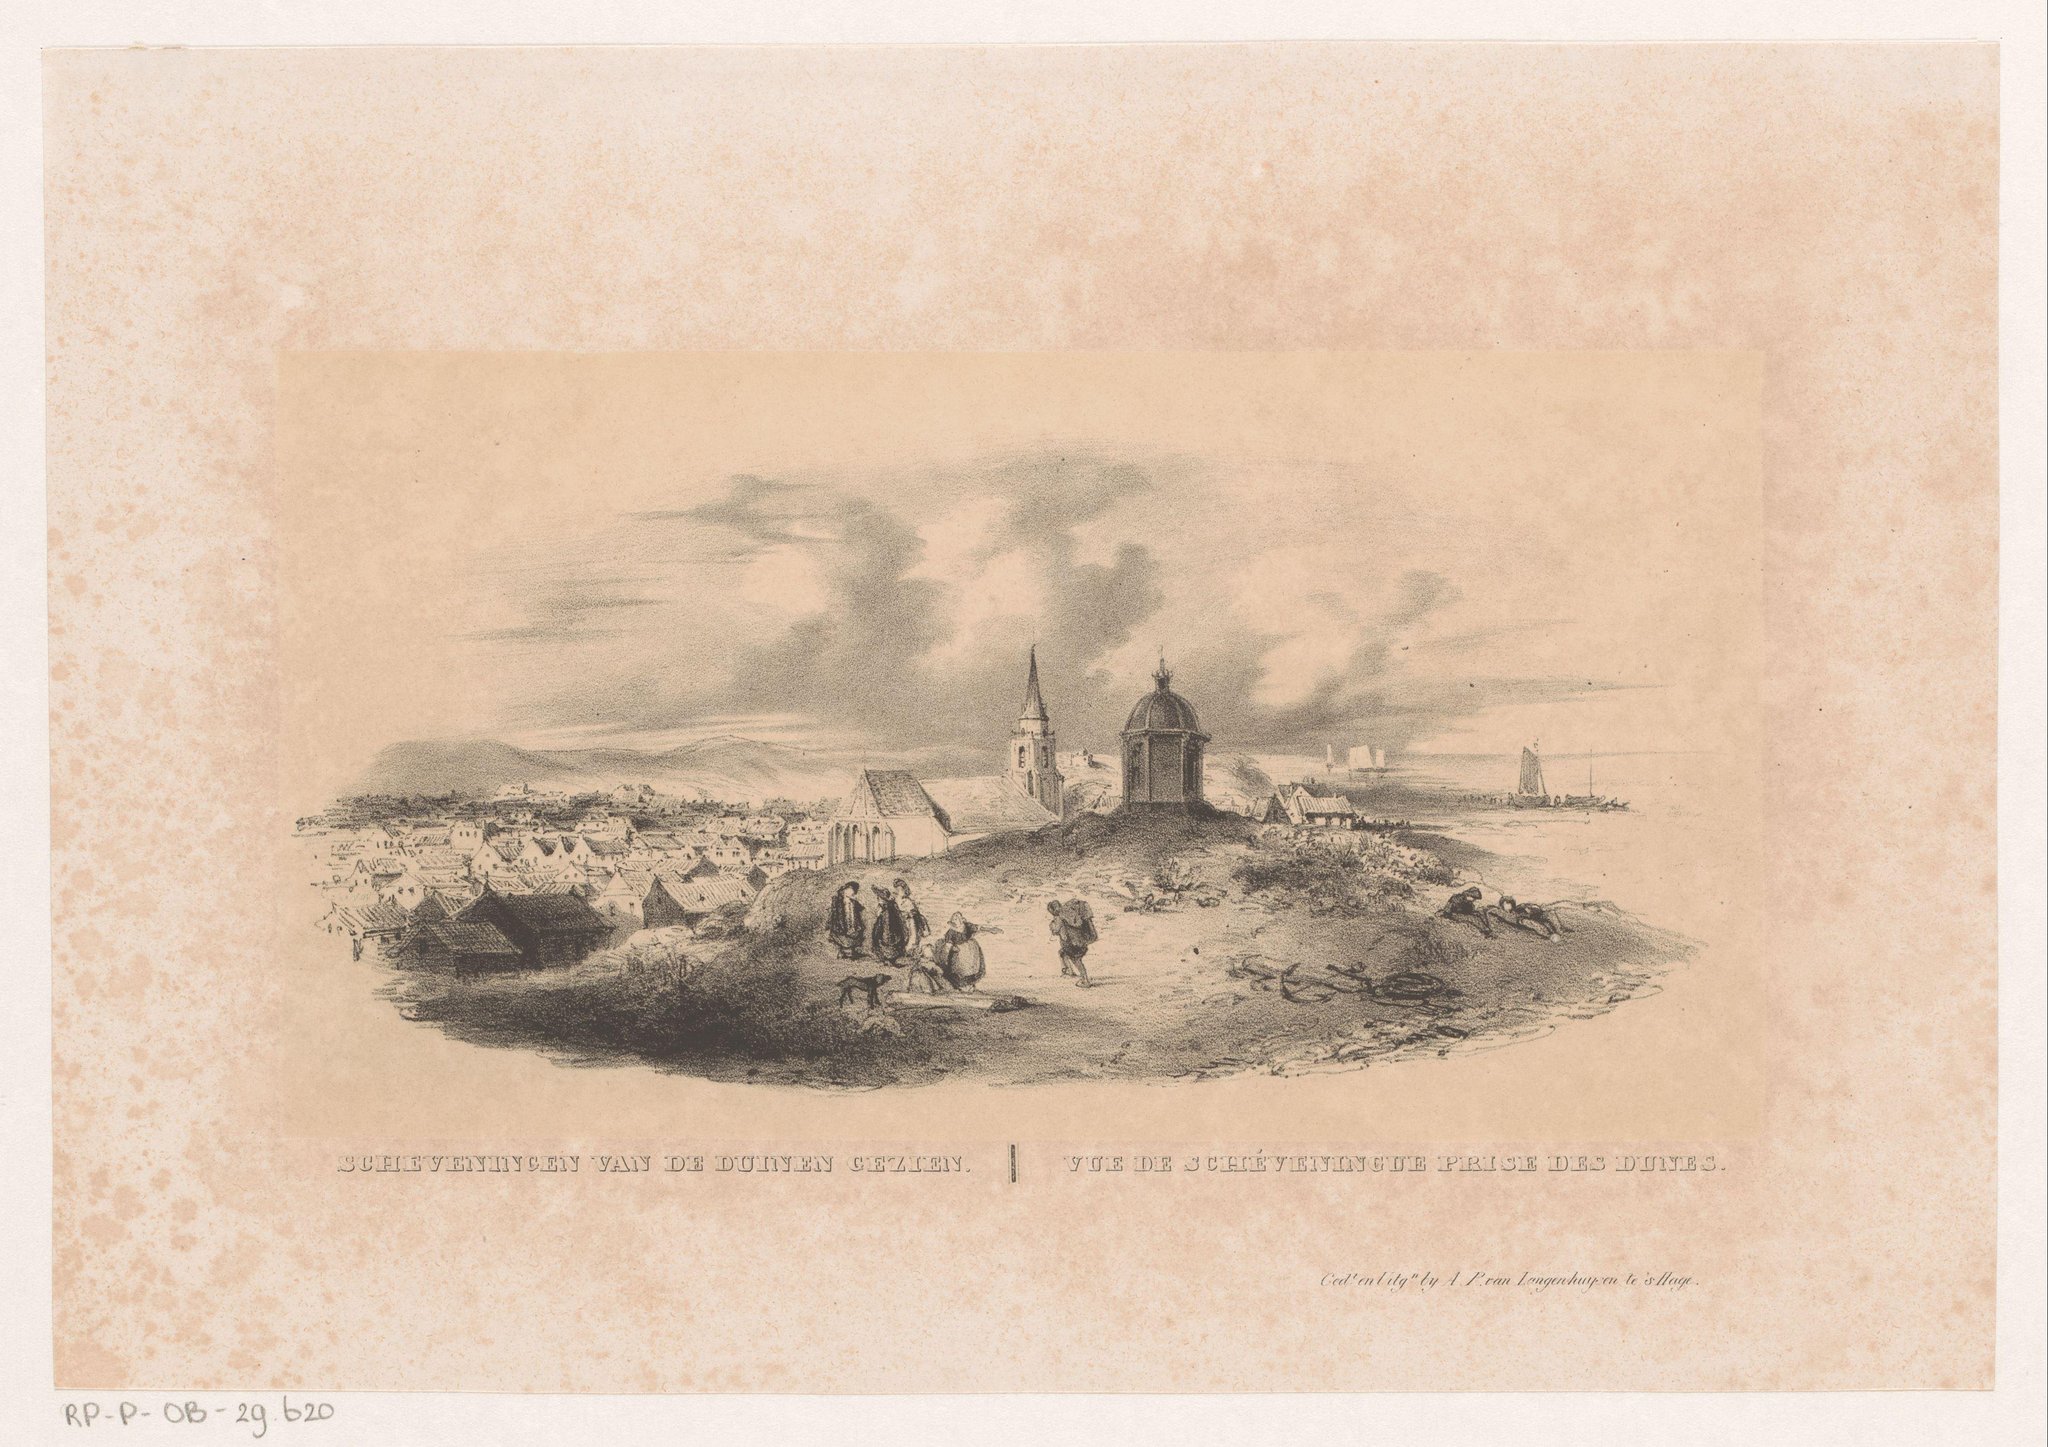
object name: print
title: Scheveningen van de duinen gezien / Vue de Schévenigue prise des dunes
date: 1830-1846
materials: paper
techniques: tone lithography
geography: the hague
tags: dune coast, city-view in general; 'veduta'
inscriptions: collector's mark: Lugt 2228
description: Gezicht op Scheveningen vanaf de duinen gezien. In de duinen lopen figuren met een hond. Rechts ligt de zee.